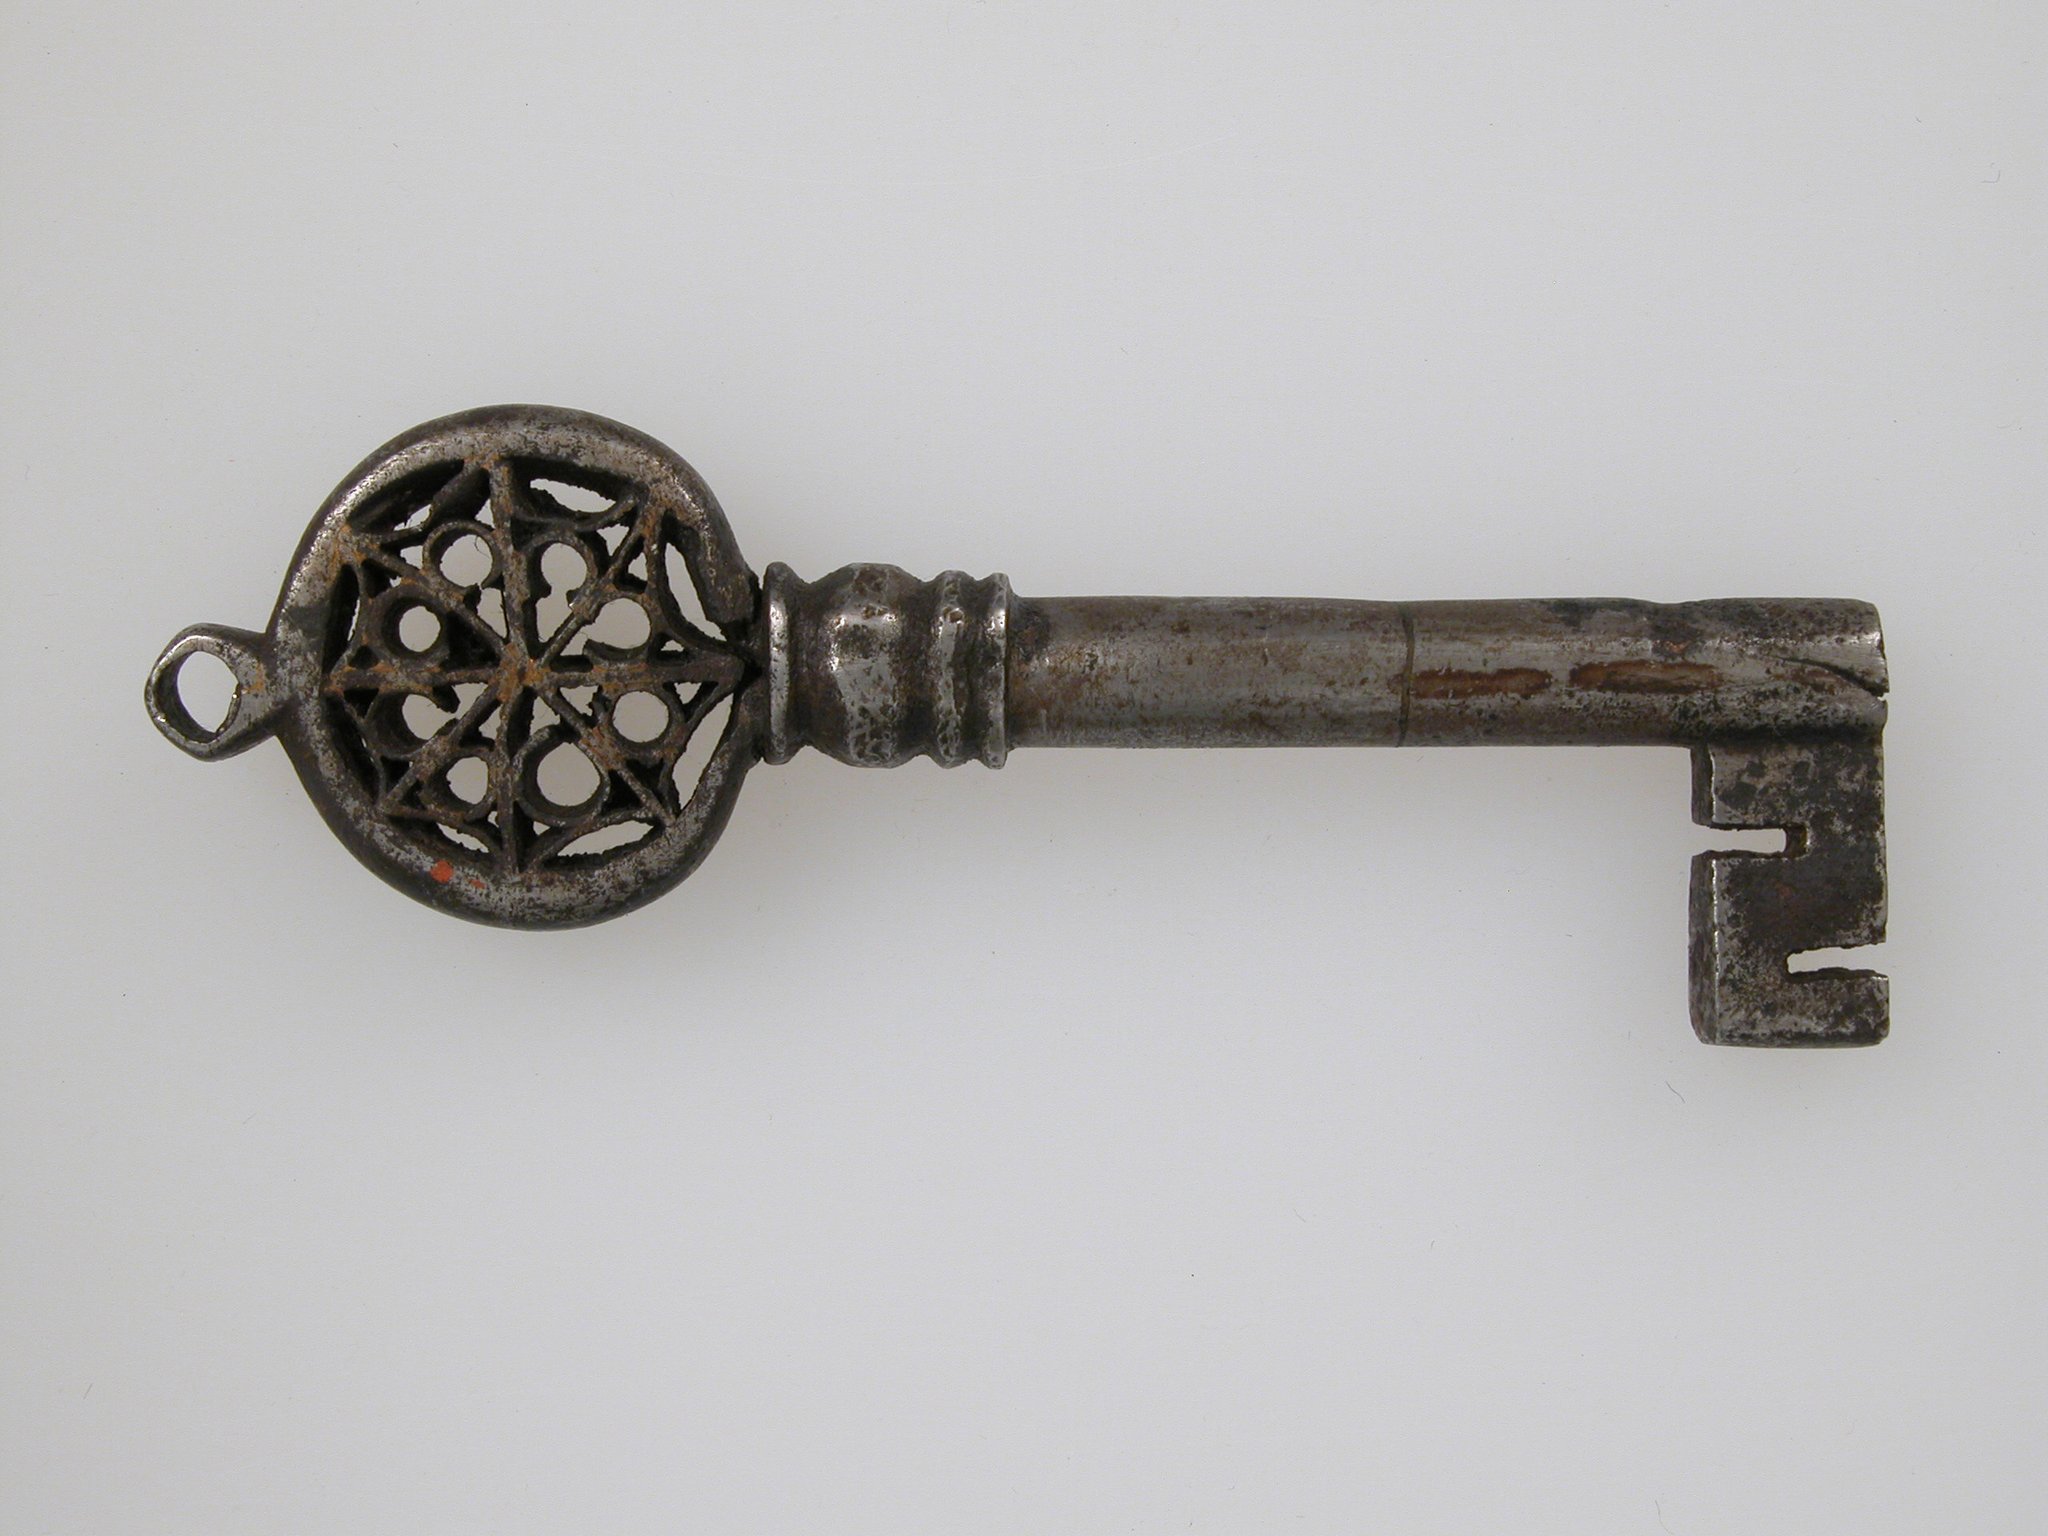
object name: key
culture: catalan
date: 1501-1600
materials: iron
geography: spain